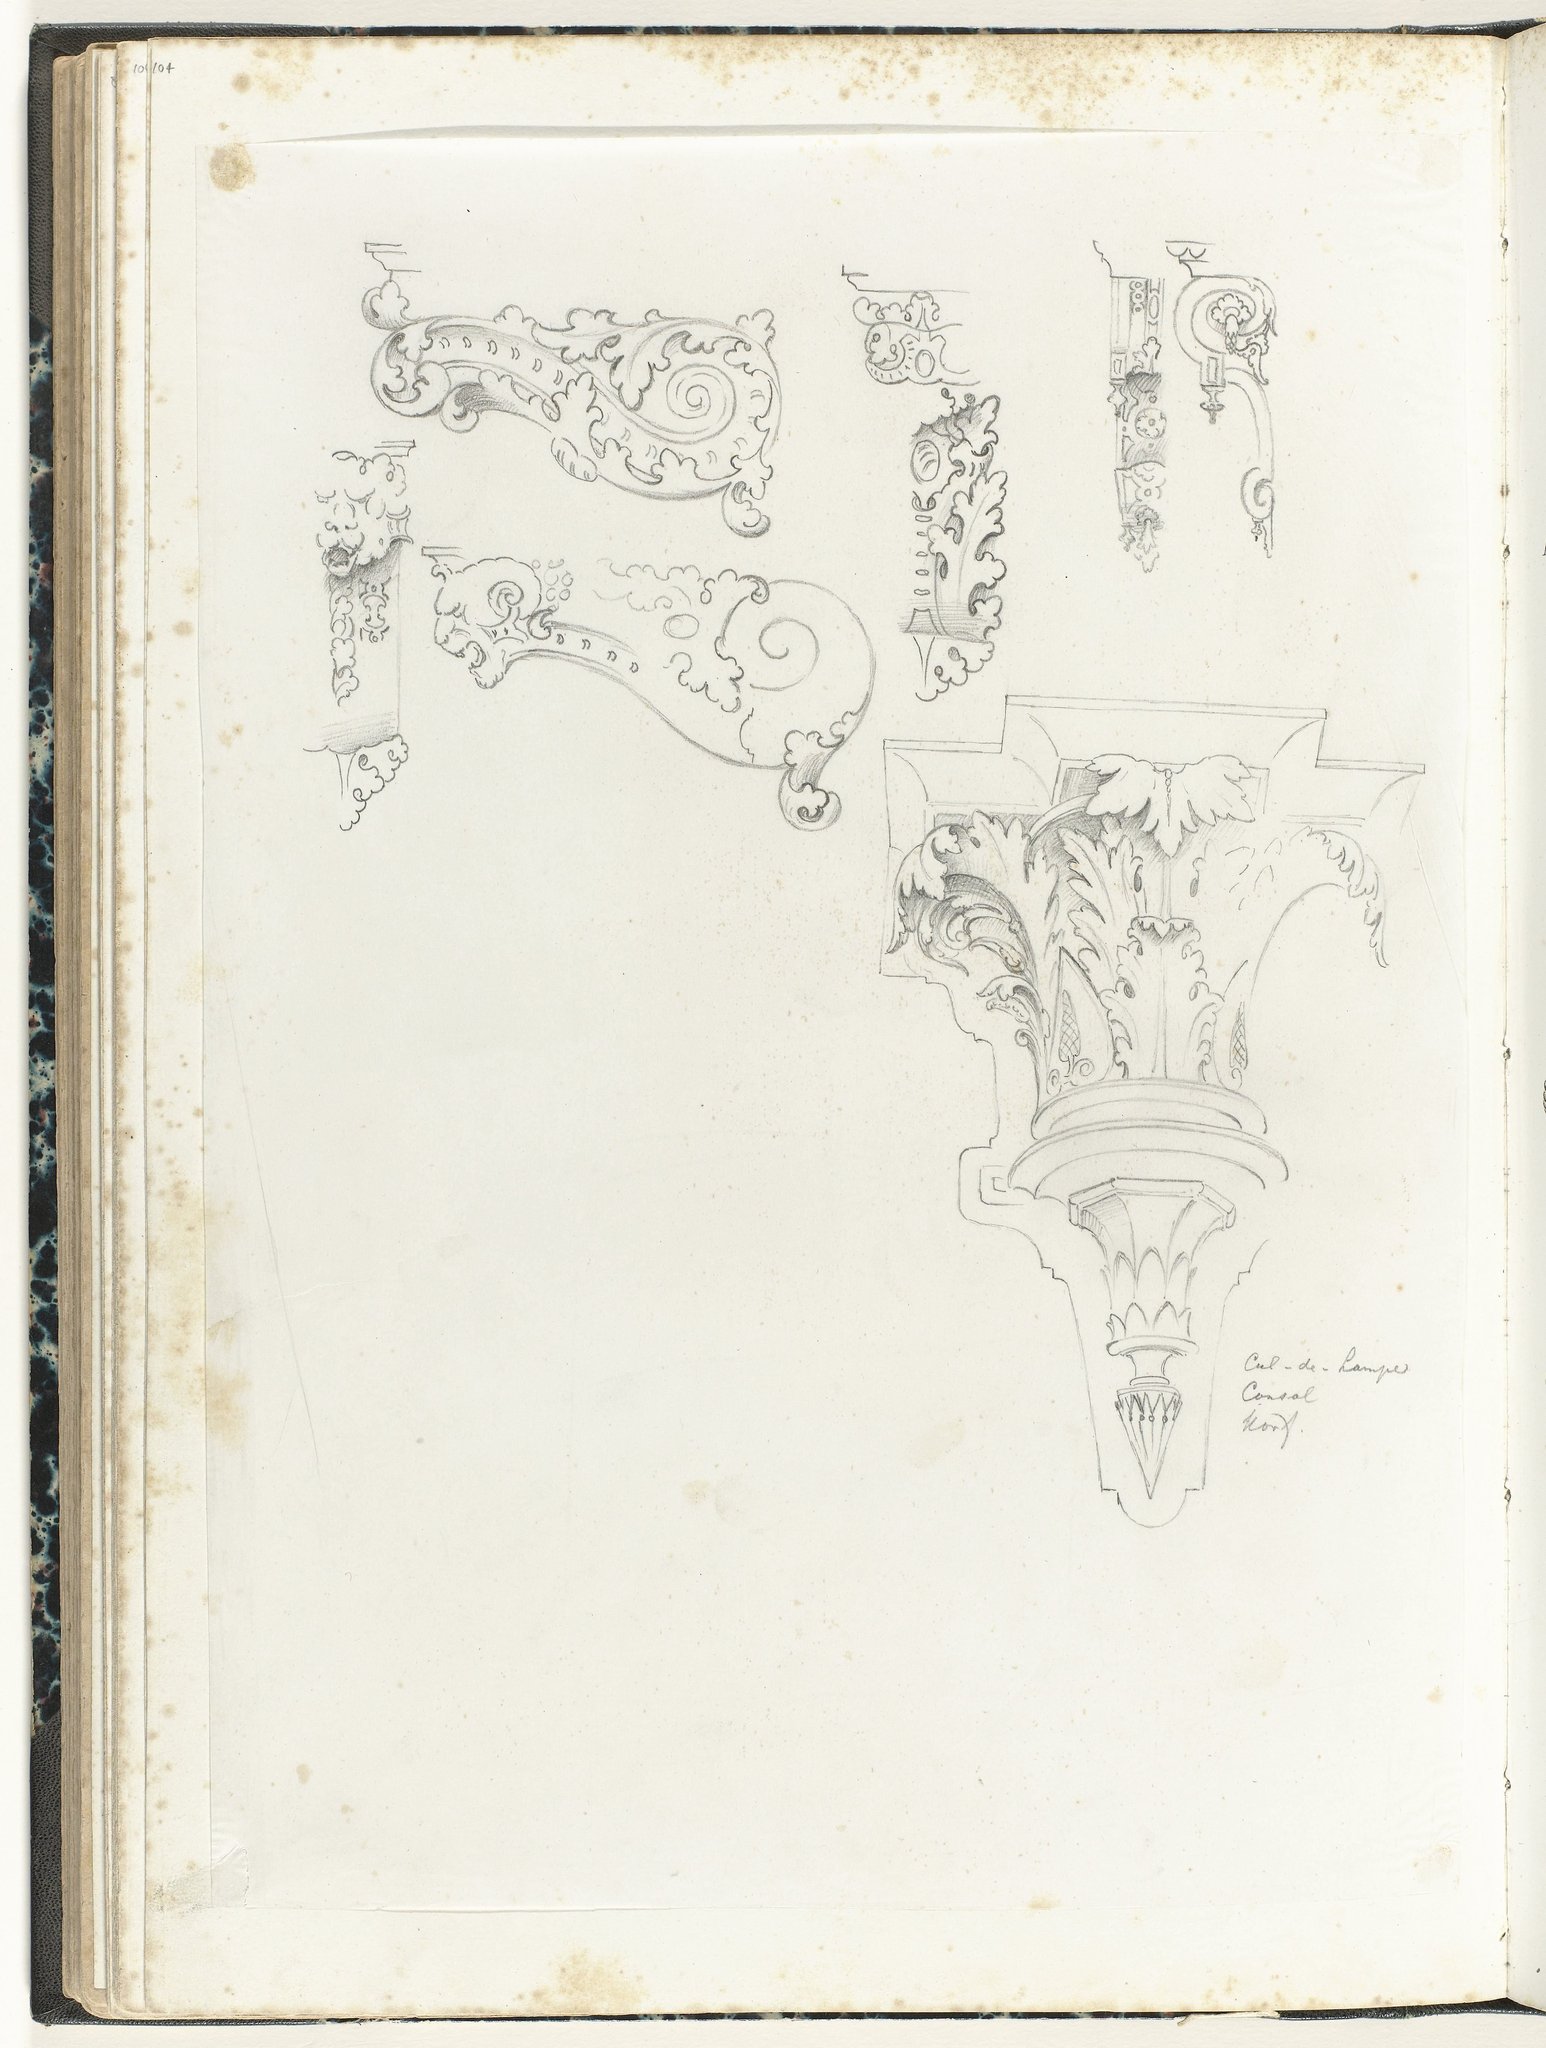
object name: drawing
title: Acht culs-de-lampe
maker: Anonymous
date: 1866-1900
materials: pencil, paper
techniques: drawing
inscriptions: annotation: ‘Cul-de -Lampe Consol Korf (?).’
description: Rechtsonder een cul-de-lampe met acanthusbladeren.